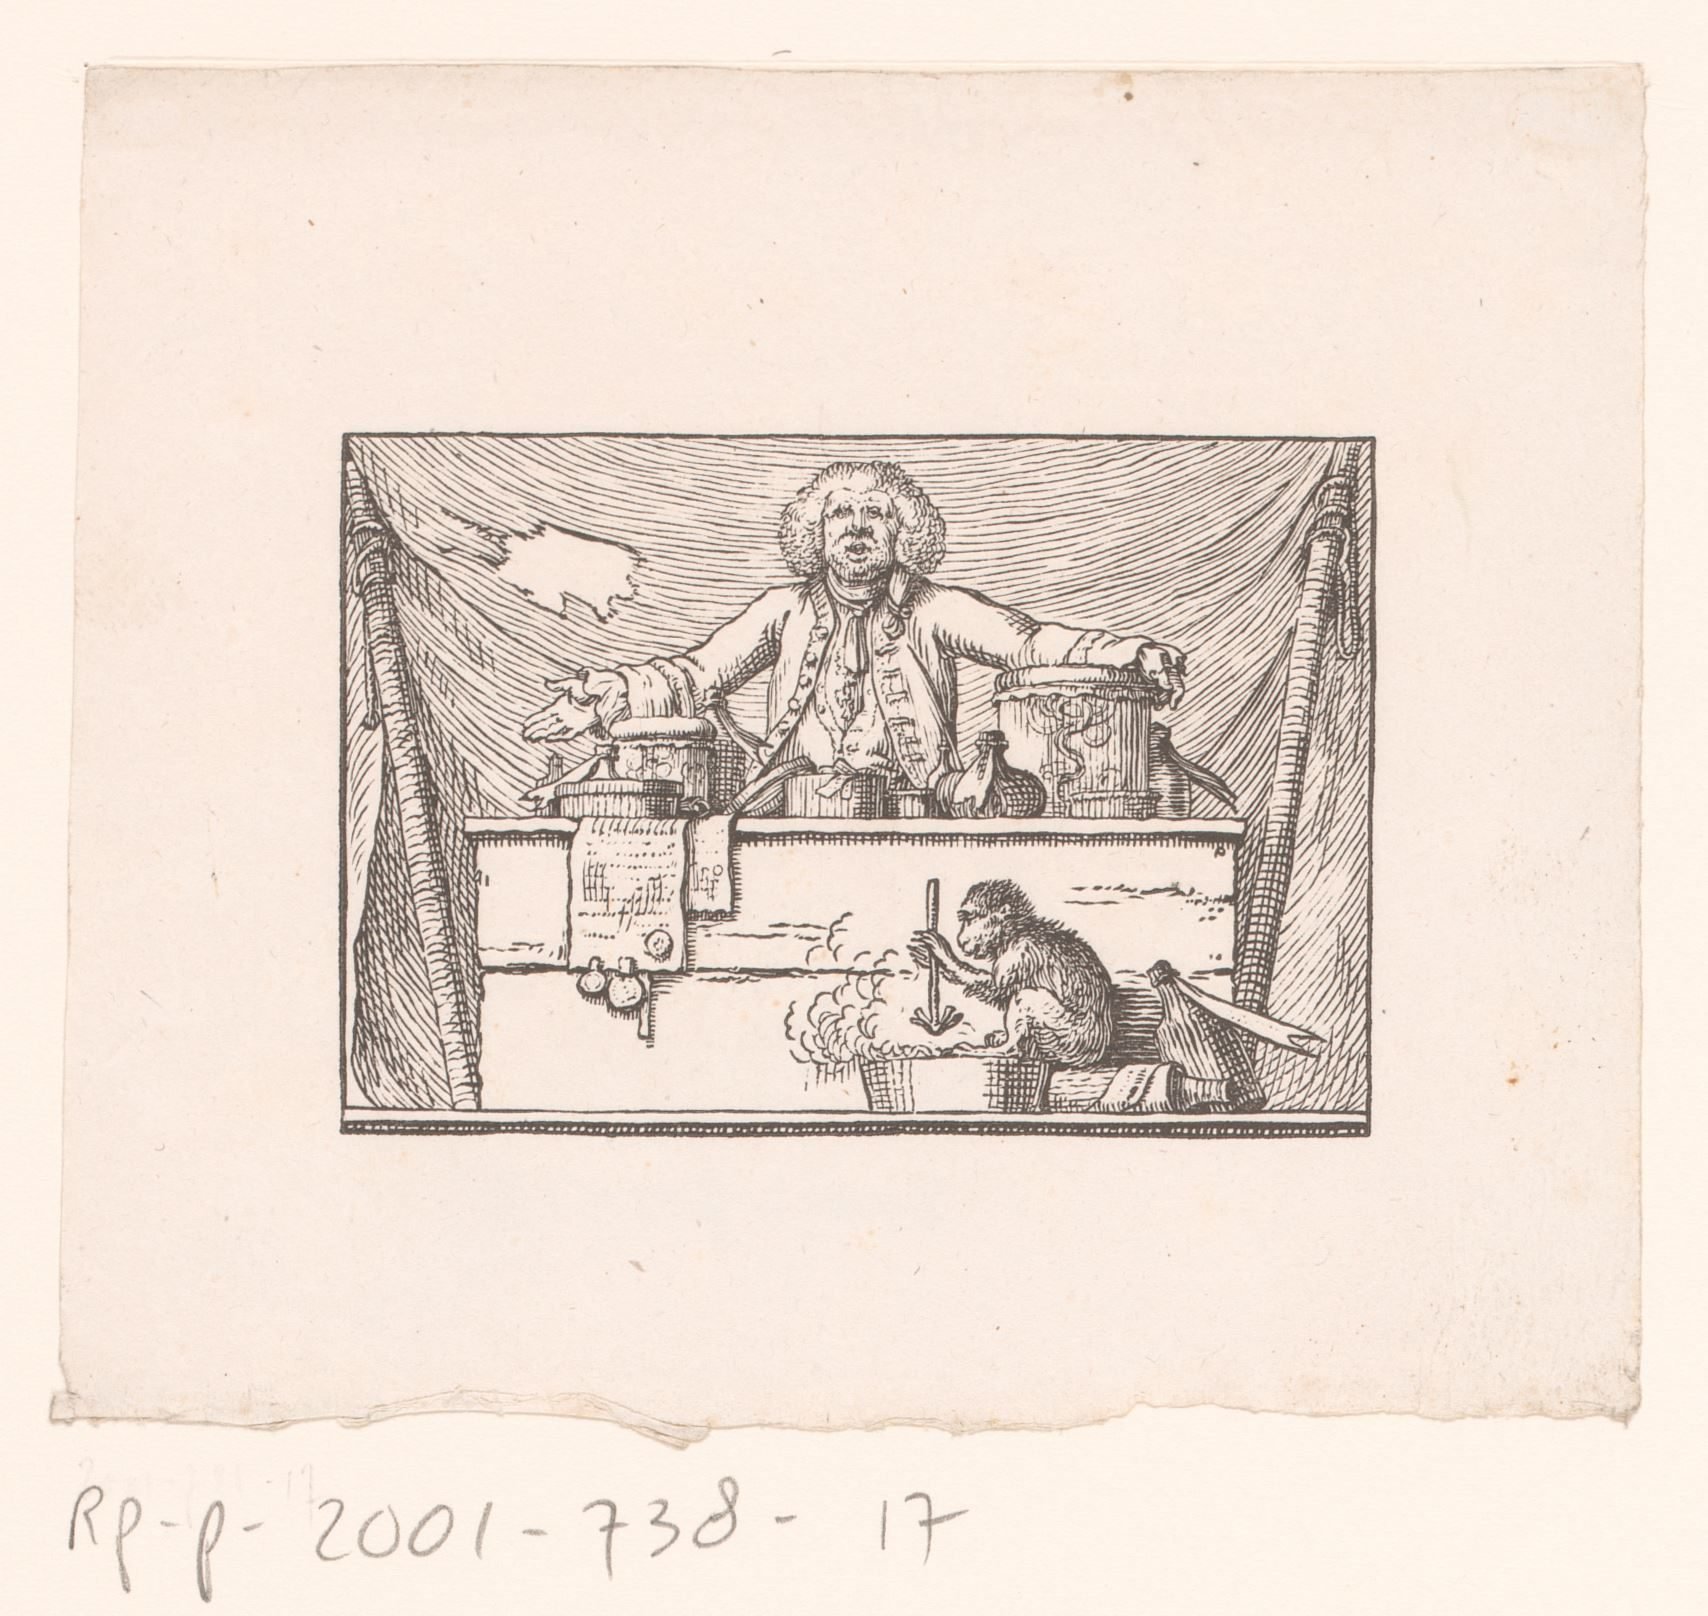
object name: print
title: 25 figuren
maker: johann friedrich gottlieb unger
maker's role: print maker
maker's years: 1753-1804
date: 1763-1804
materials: paper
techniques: woodcut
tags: human types, quack, charlatan, mountebank, 'saltimbanco'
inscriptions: collector's mark: Lugt 2228